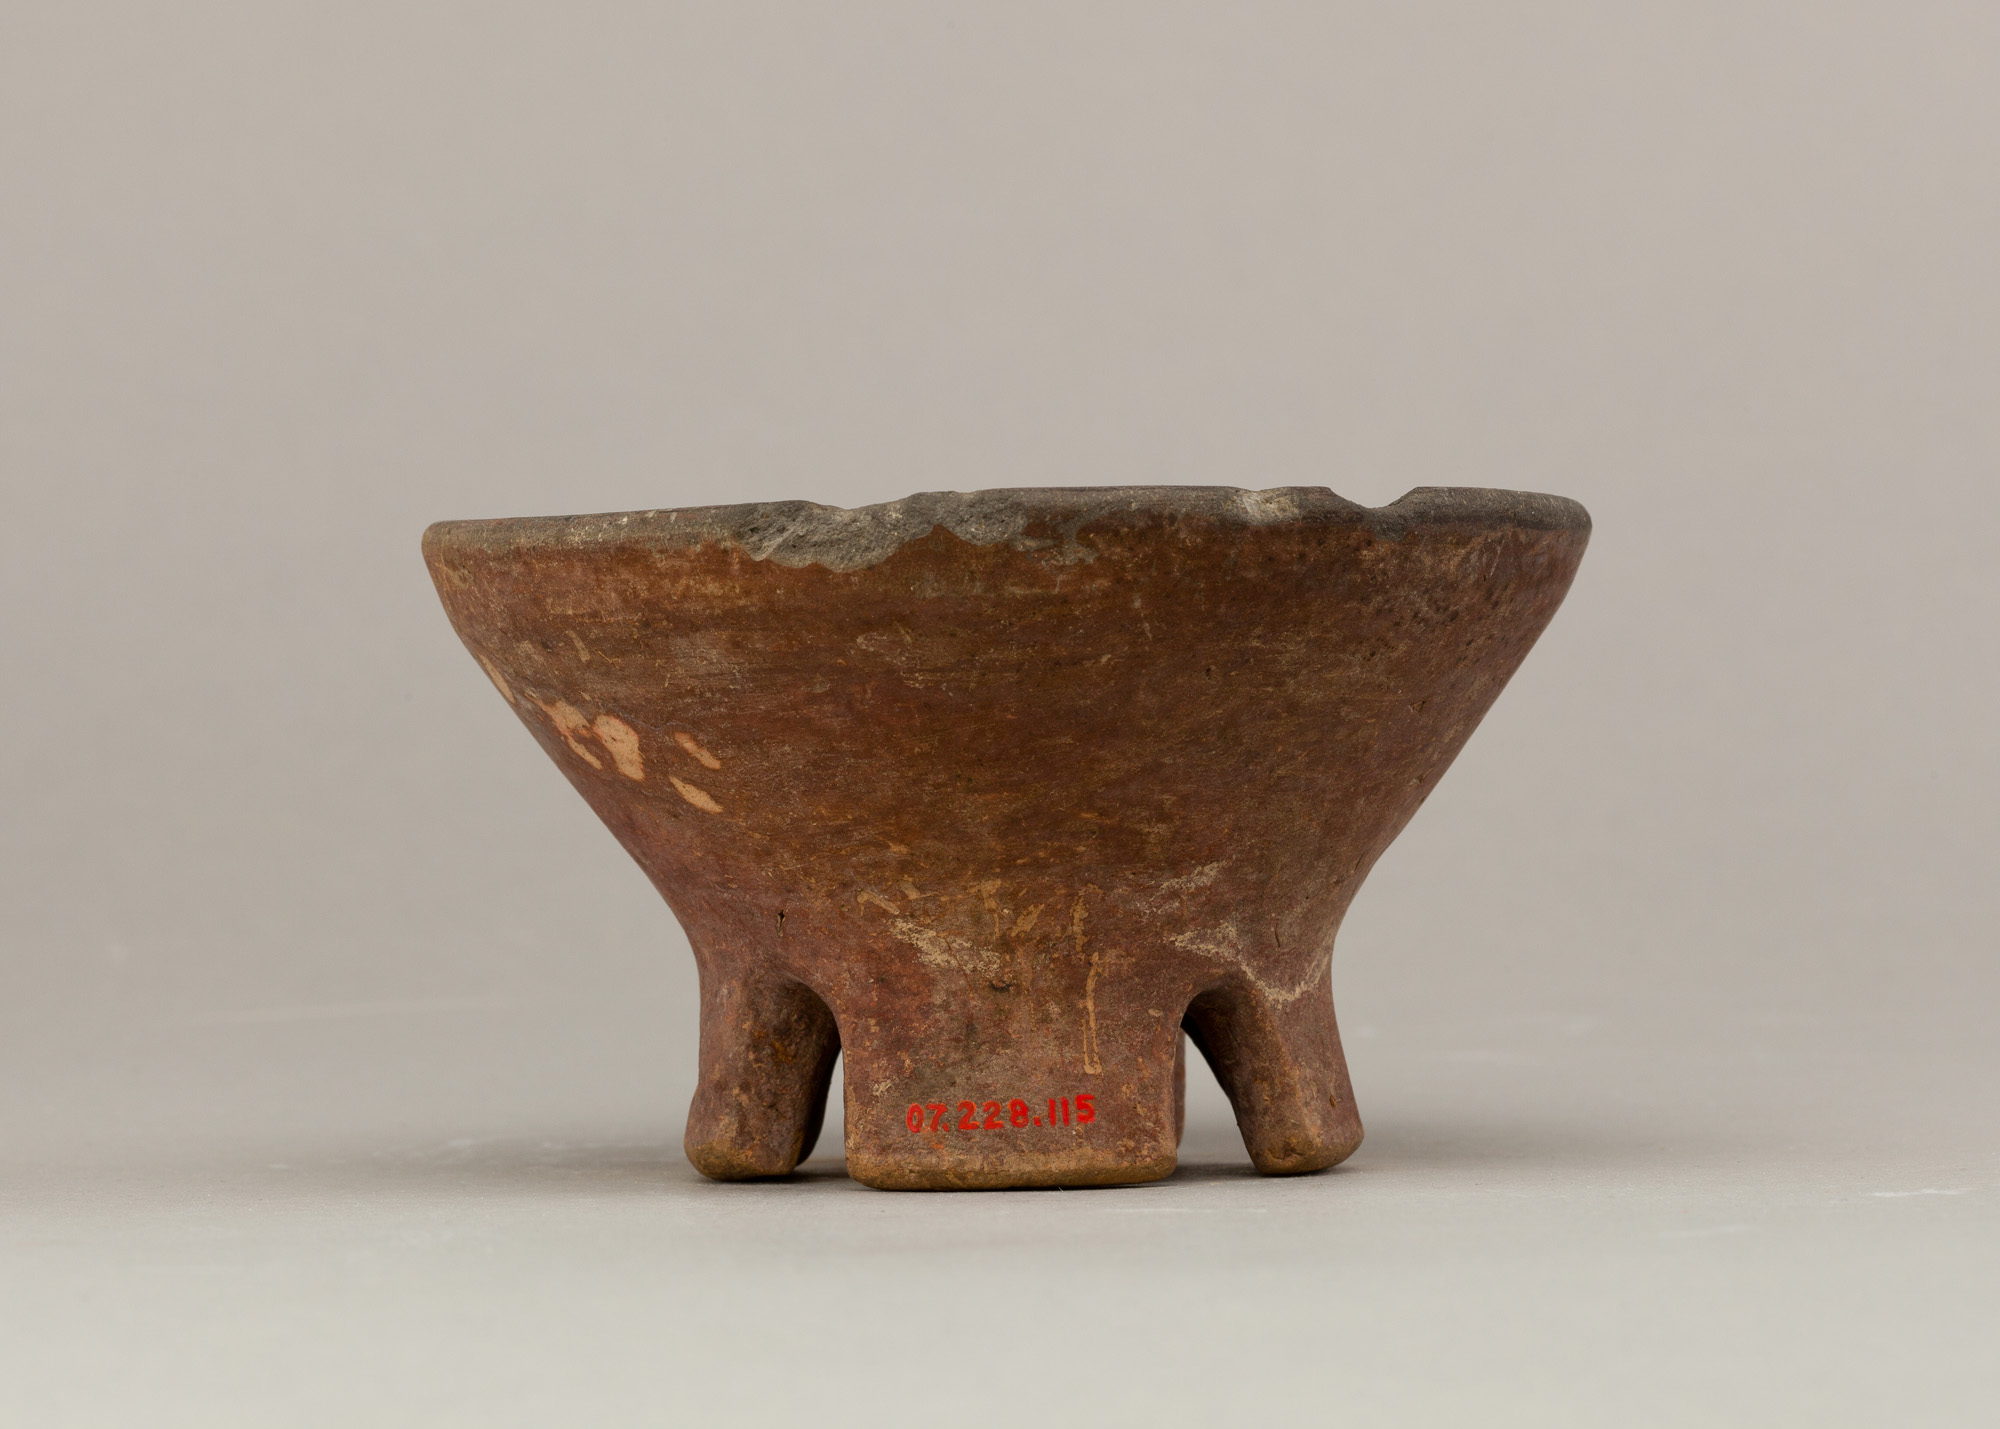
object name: bowl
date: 3850-2960 BCE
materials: pottery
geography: egypt